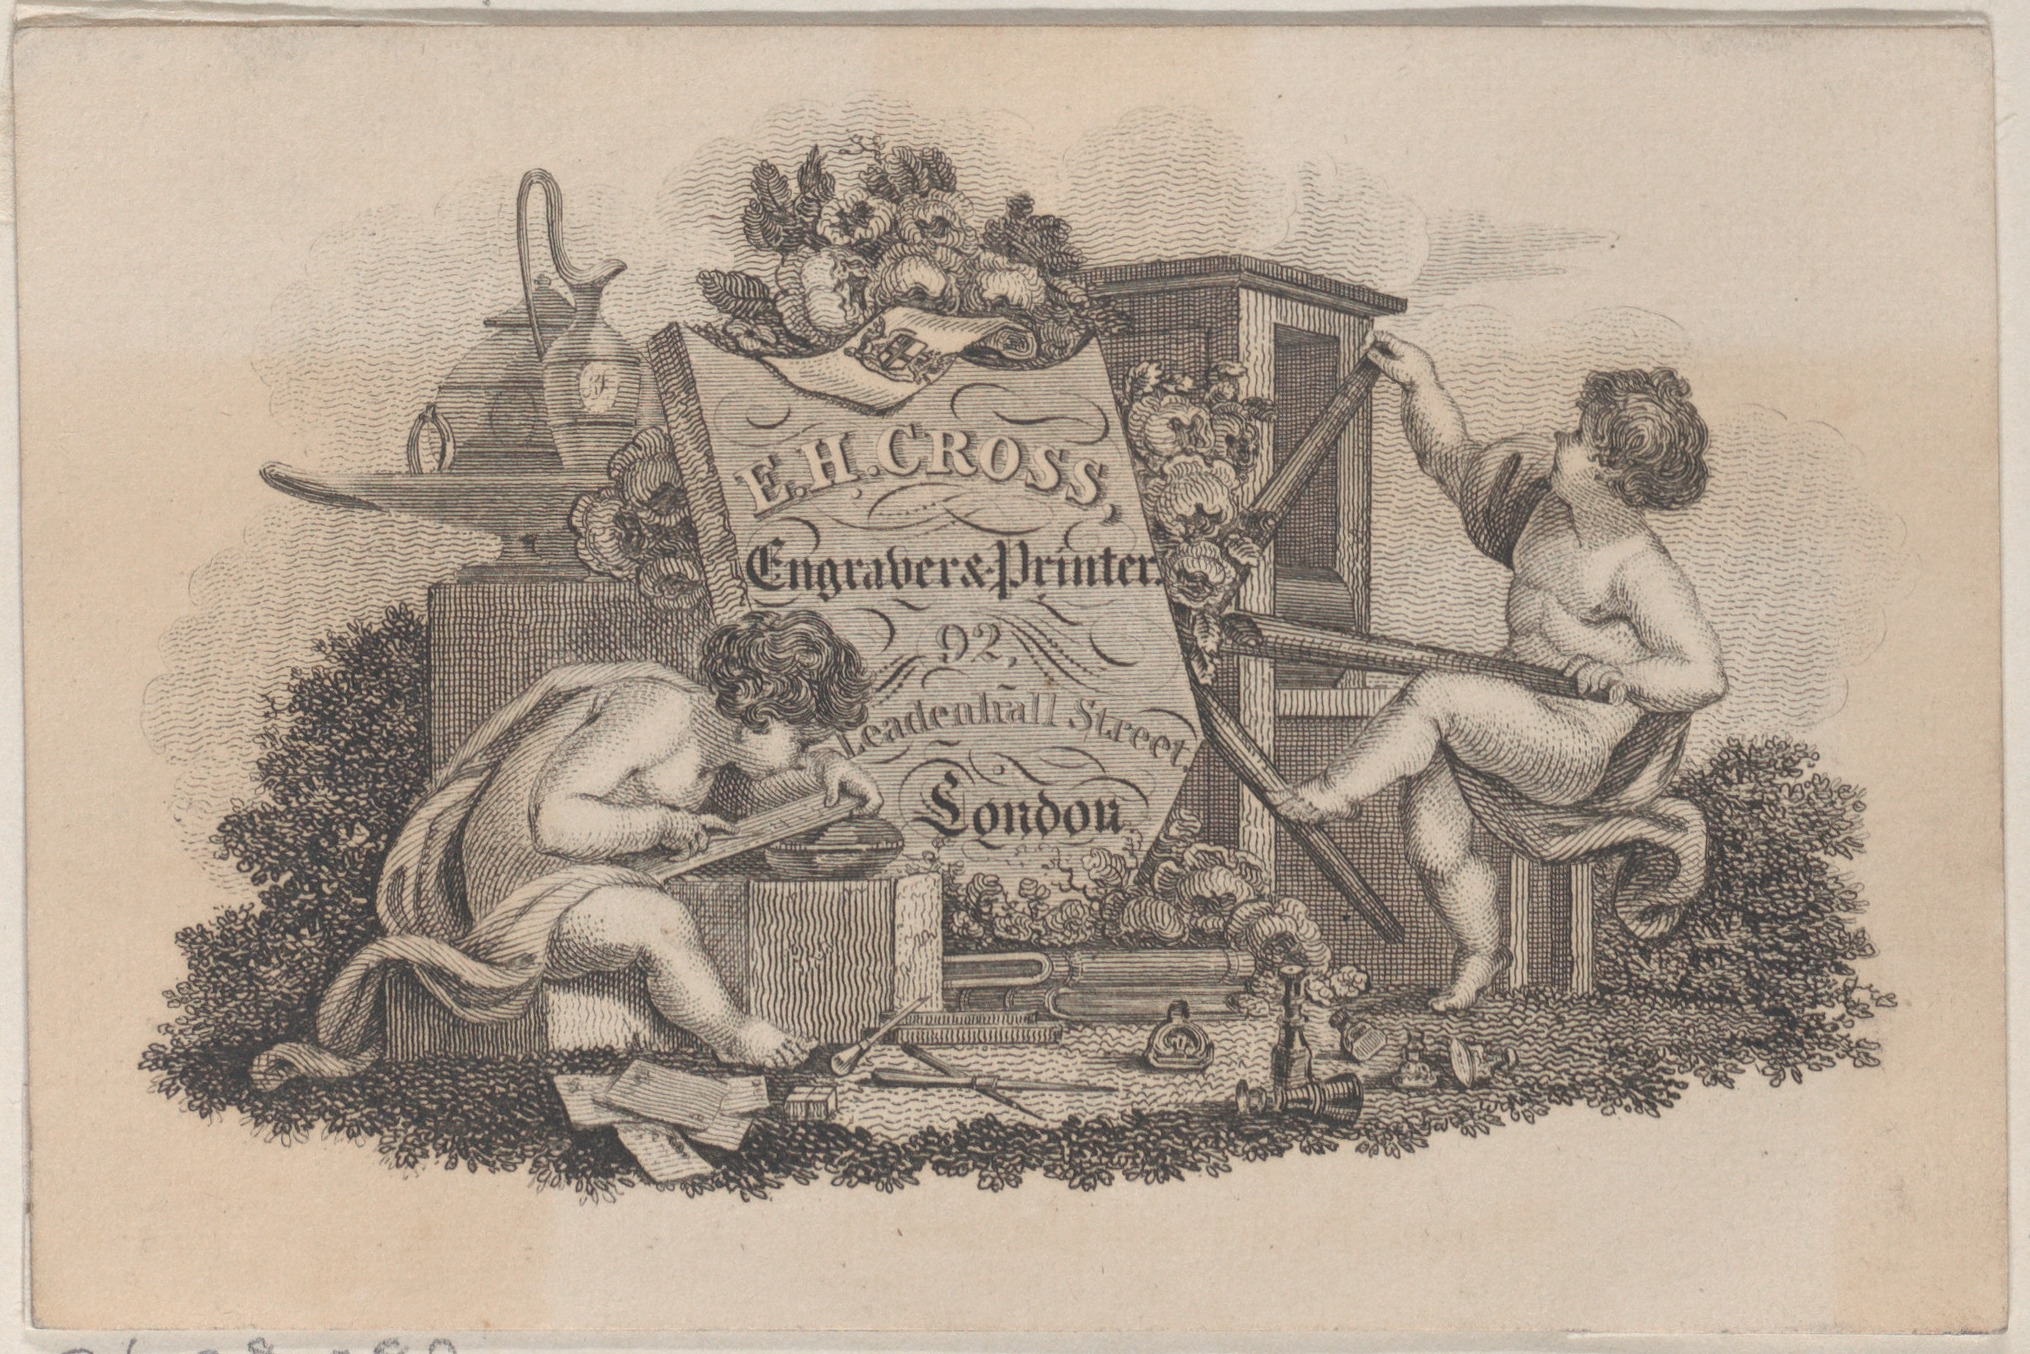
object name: print, trade card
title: Trade Card for E.H. Cross, Engraver & Printer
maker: anonymous, british, 19th century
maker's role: artist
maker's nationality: british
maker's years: 1800-1900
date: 1801-1900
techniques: engraving